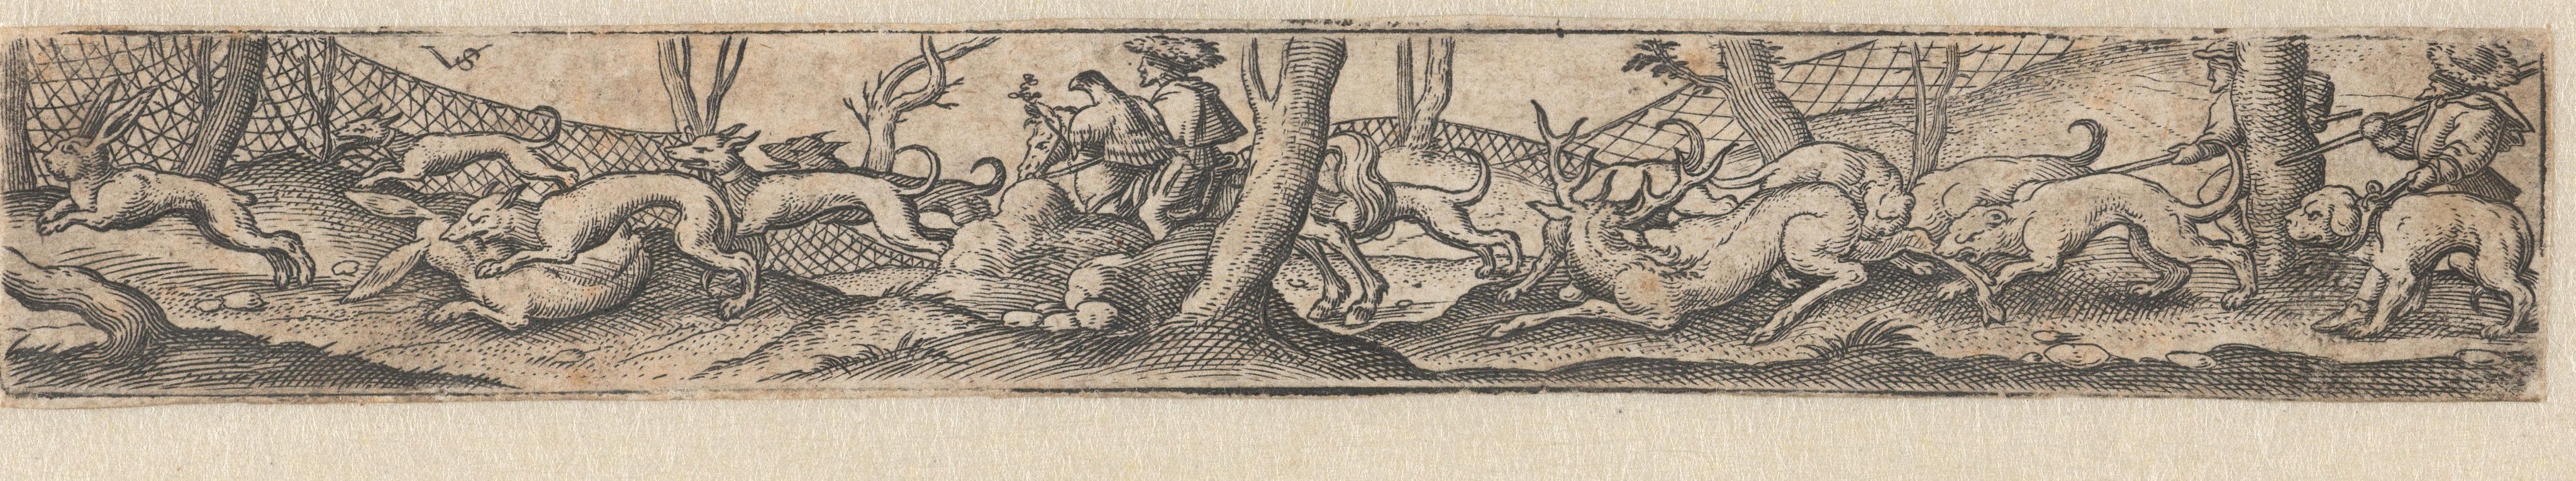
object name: print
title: Hertenjacht en hazenjacht en een valkenier te paard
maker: virgilius solis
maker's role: draughtsman, print maker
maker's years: 1514-1562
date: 1524-1562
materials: paper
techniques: engraving, etching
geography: nuremberg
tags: riding a horse, ass, or mule; rider, horseman, predatory birds: falcon, stag-hunting, hare-hunting, rabbit-hunting